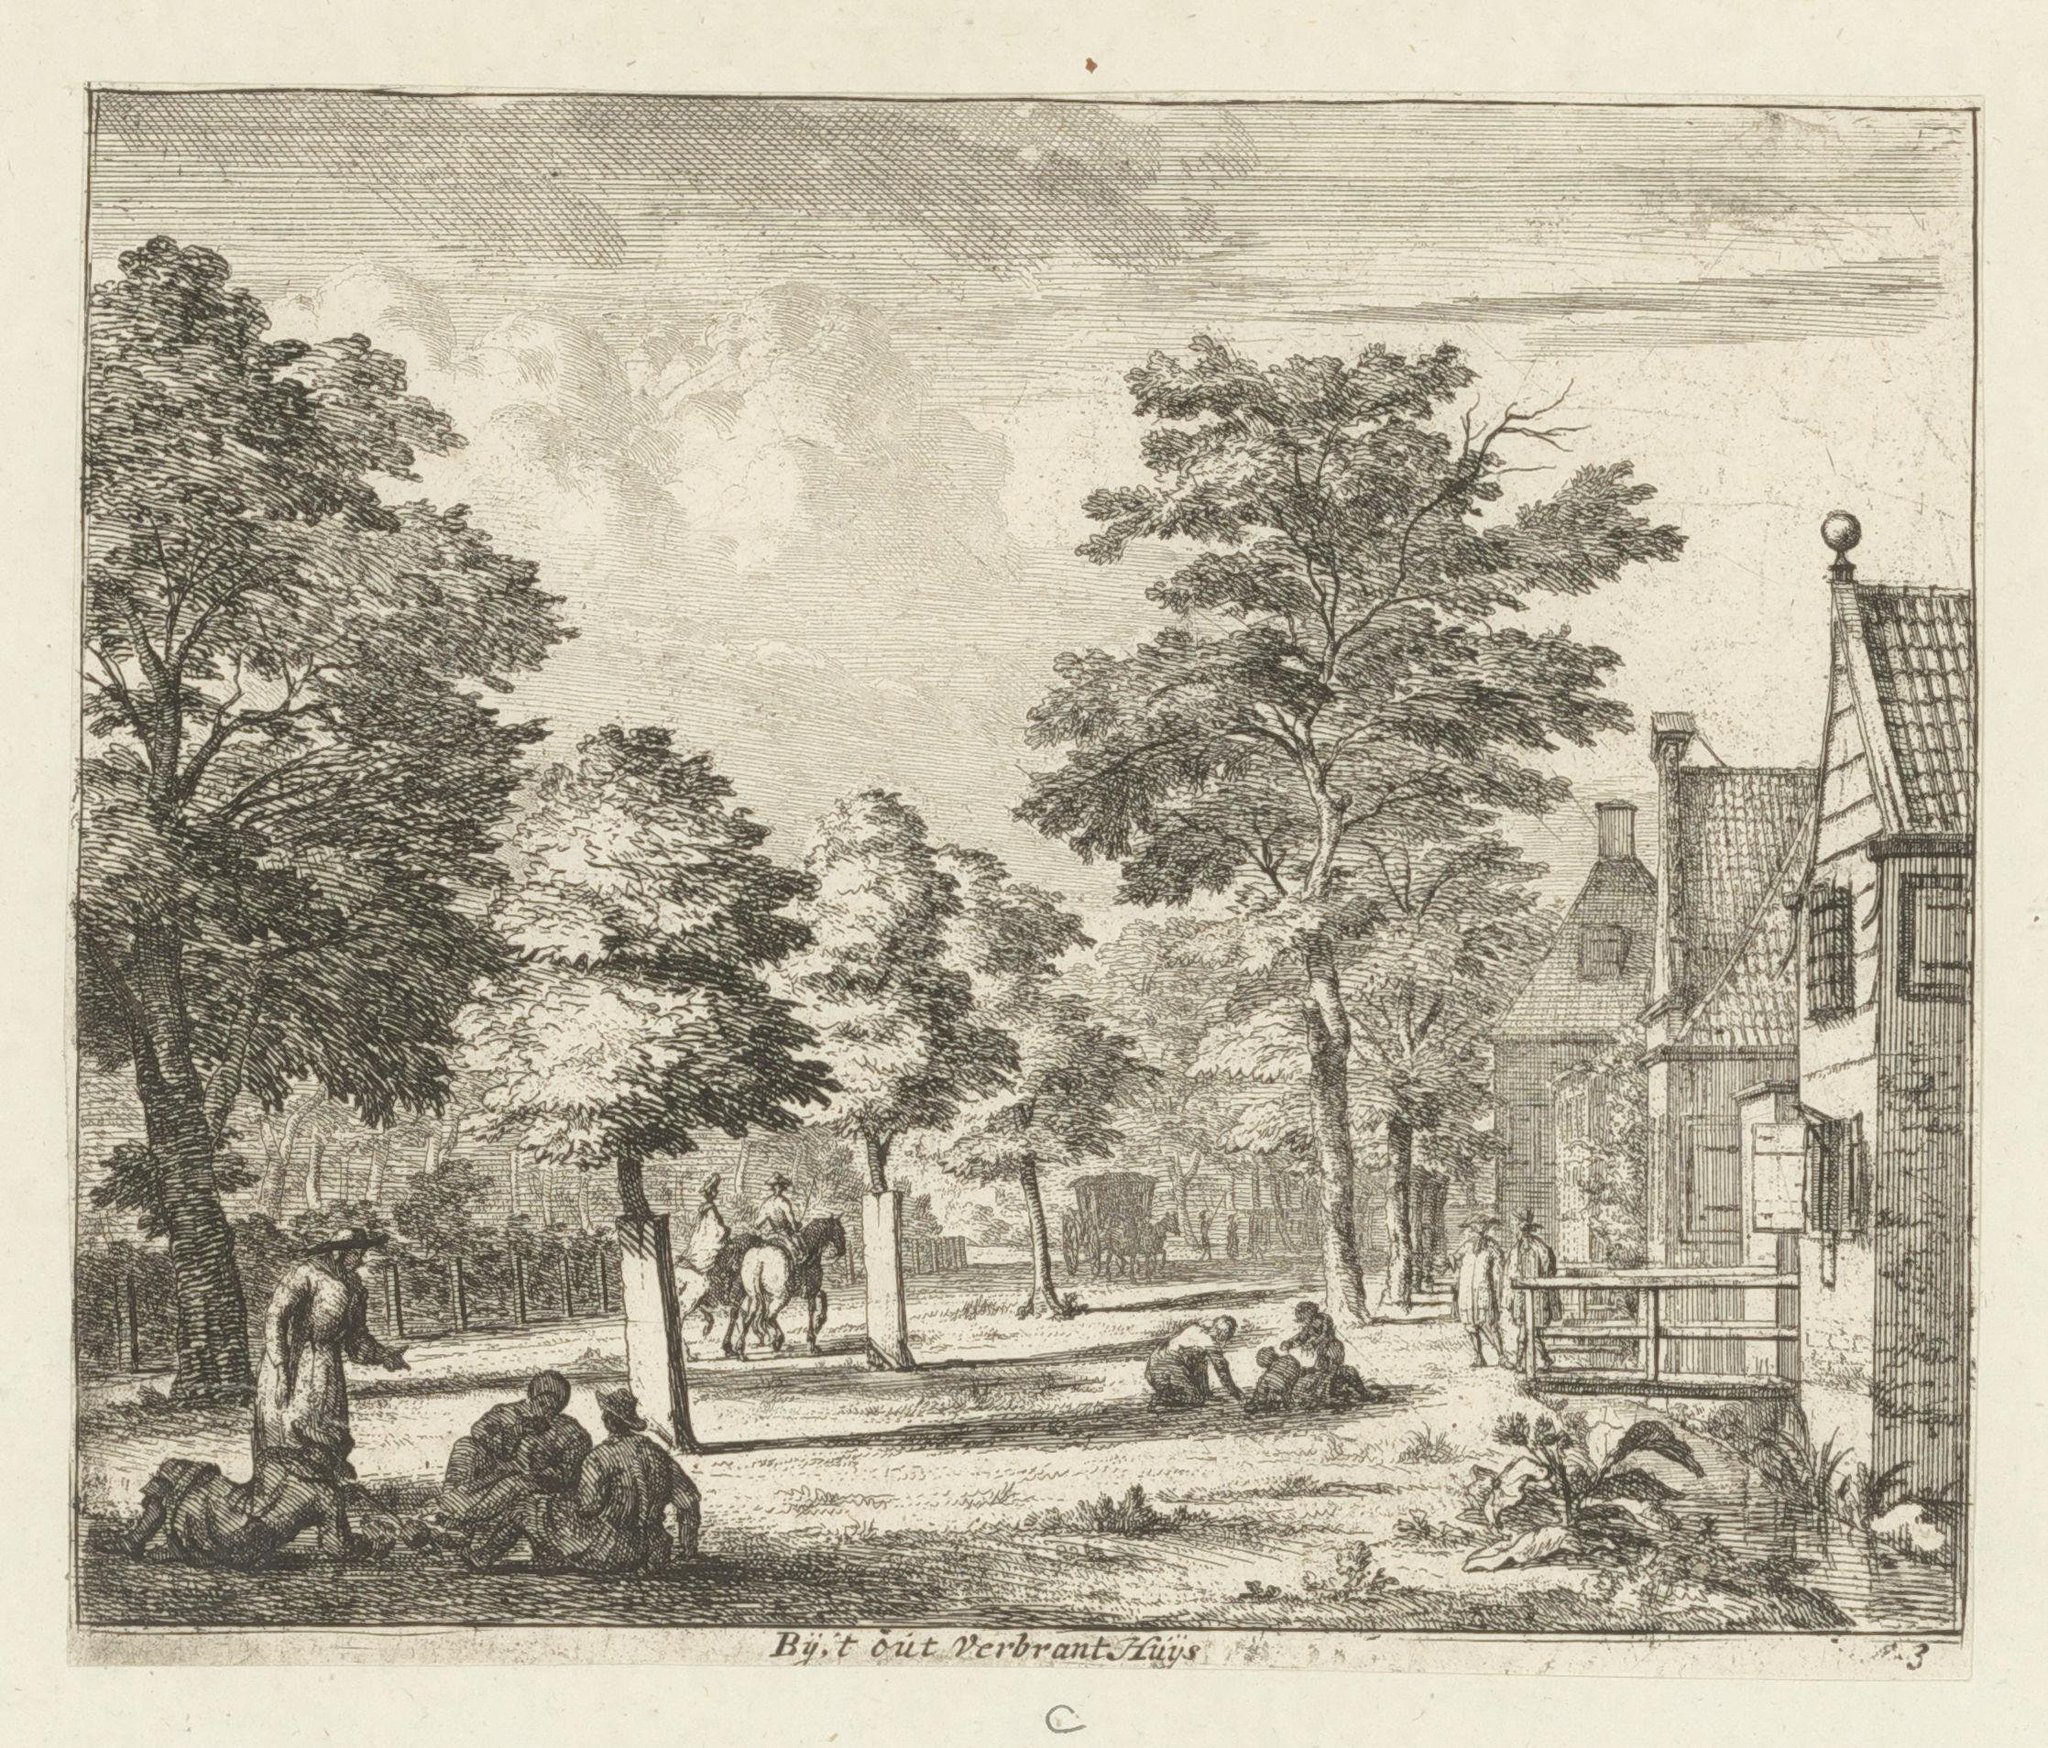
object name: print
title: Gesigten Buijten Haarlem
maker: jan vincentsz. van der vinne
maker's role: draughtsman, print maker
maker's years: 1663-1721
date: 1688-1690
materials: paper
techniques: engraving, etching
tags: riding a horse, ass, or mule; rider, horseman, trees, sitting on the ground, landscapes (+ landscape with figures, staffage), haarlem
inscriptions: stamp, collector's mark: Lugt 1641, stamp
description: Gezicht op de ingang van Den Hout te Haarlem. Rechtsonder genummerd: 3. Onderwerpsrubrieken binnen de Atlas Zeden en Gewoonten: Handel, nijverheid en verkeer, Buitenleven.